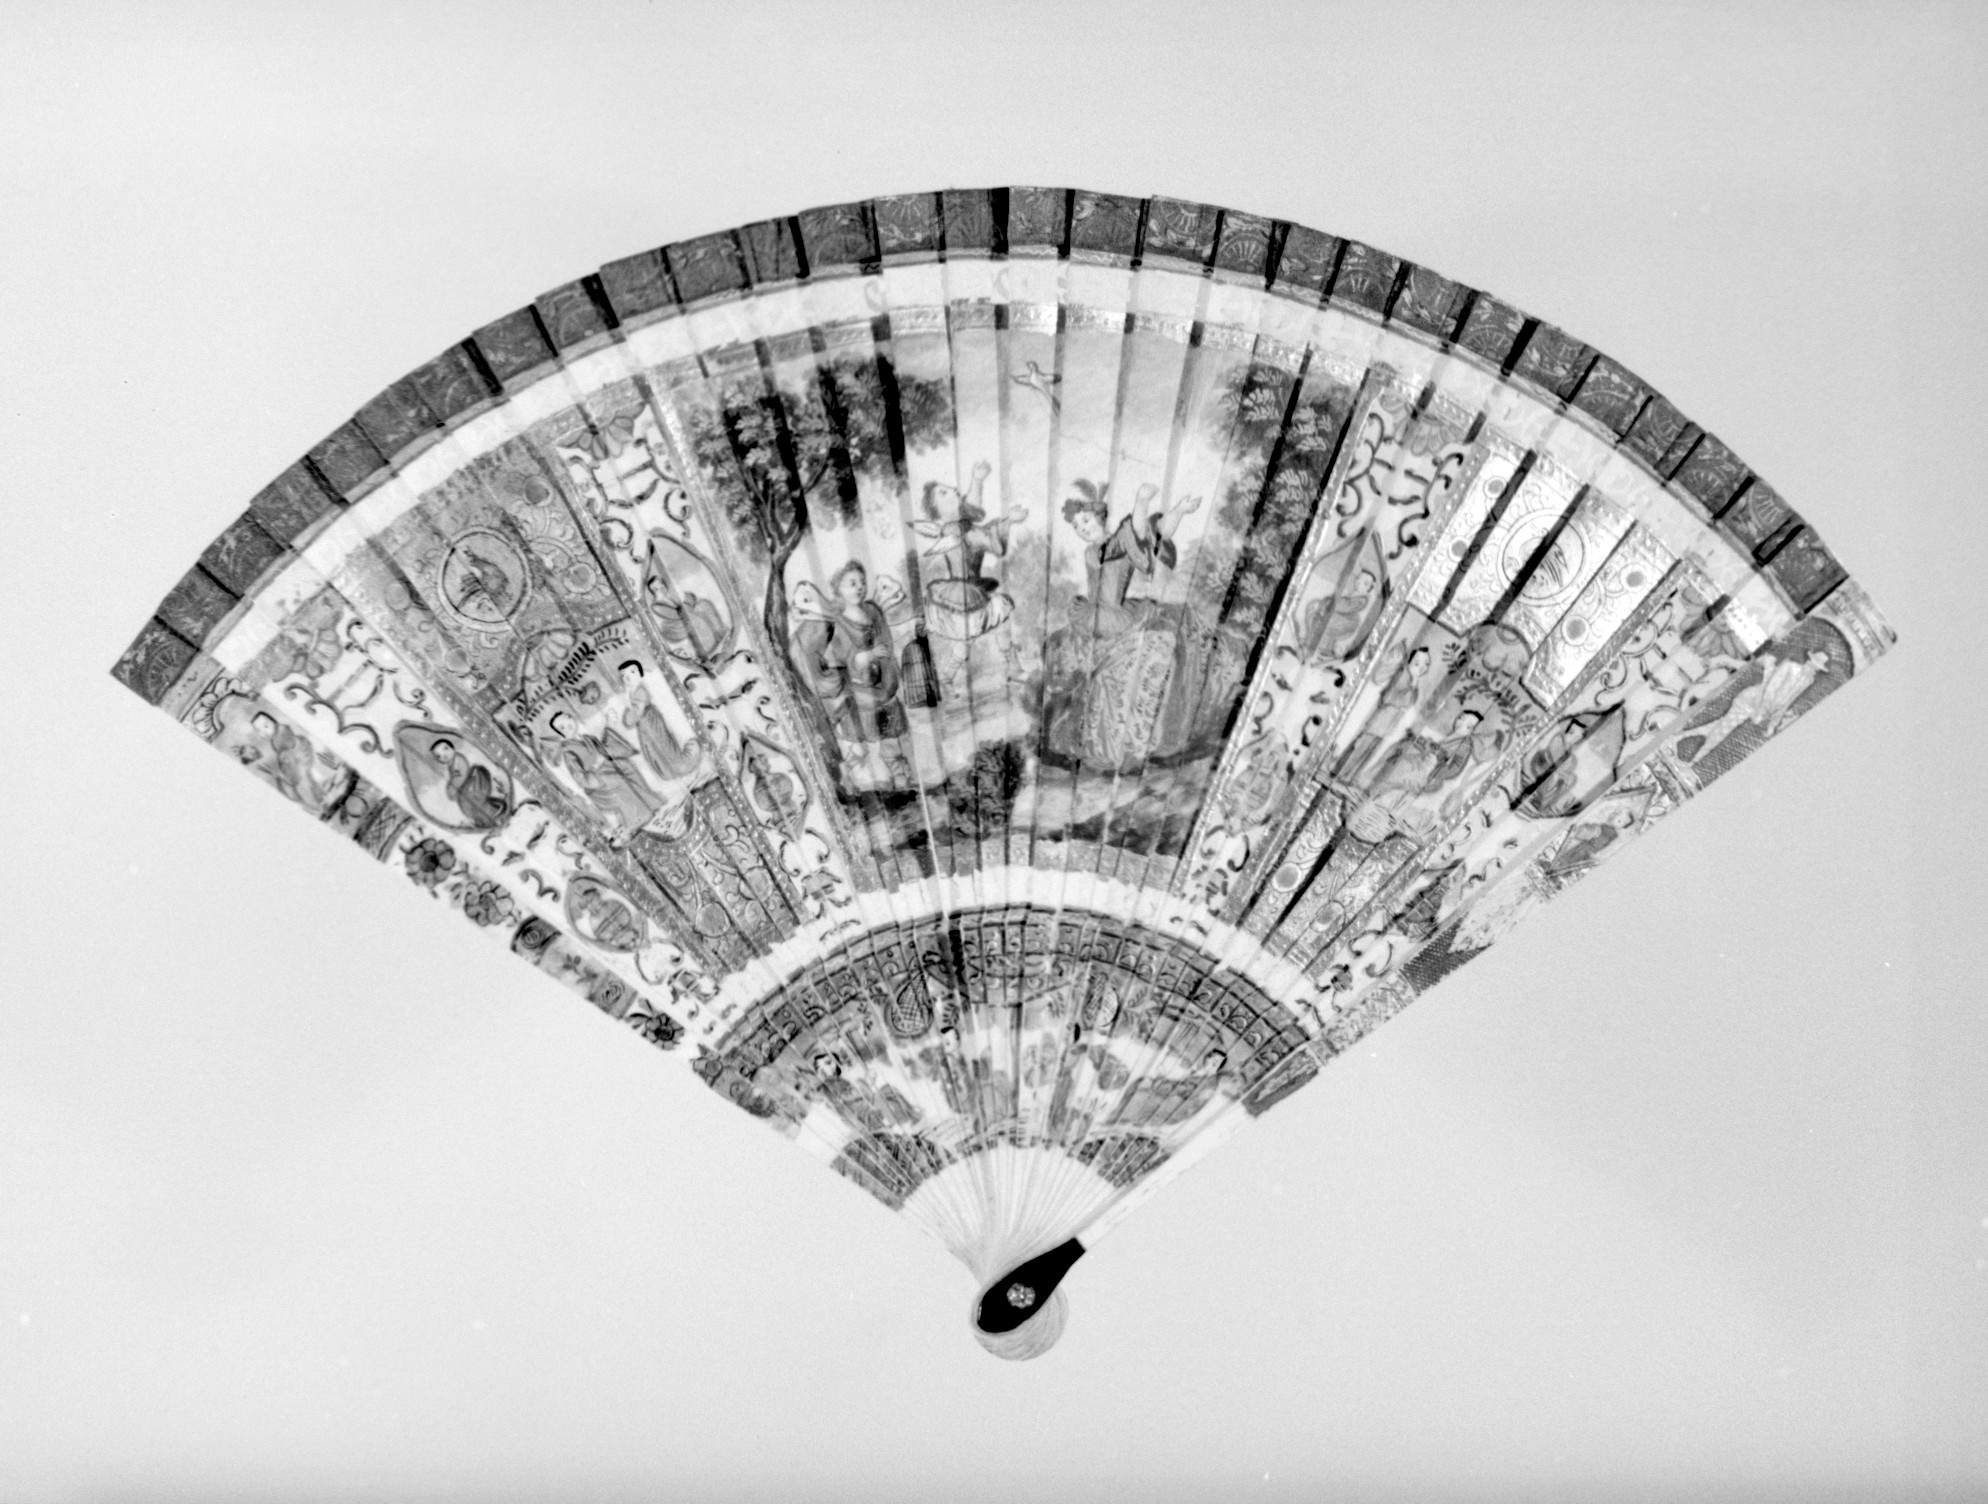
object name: fan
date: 1701-1800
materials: ivory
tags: birds,women